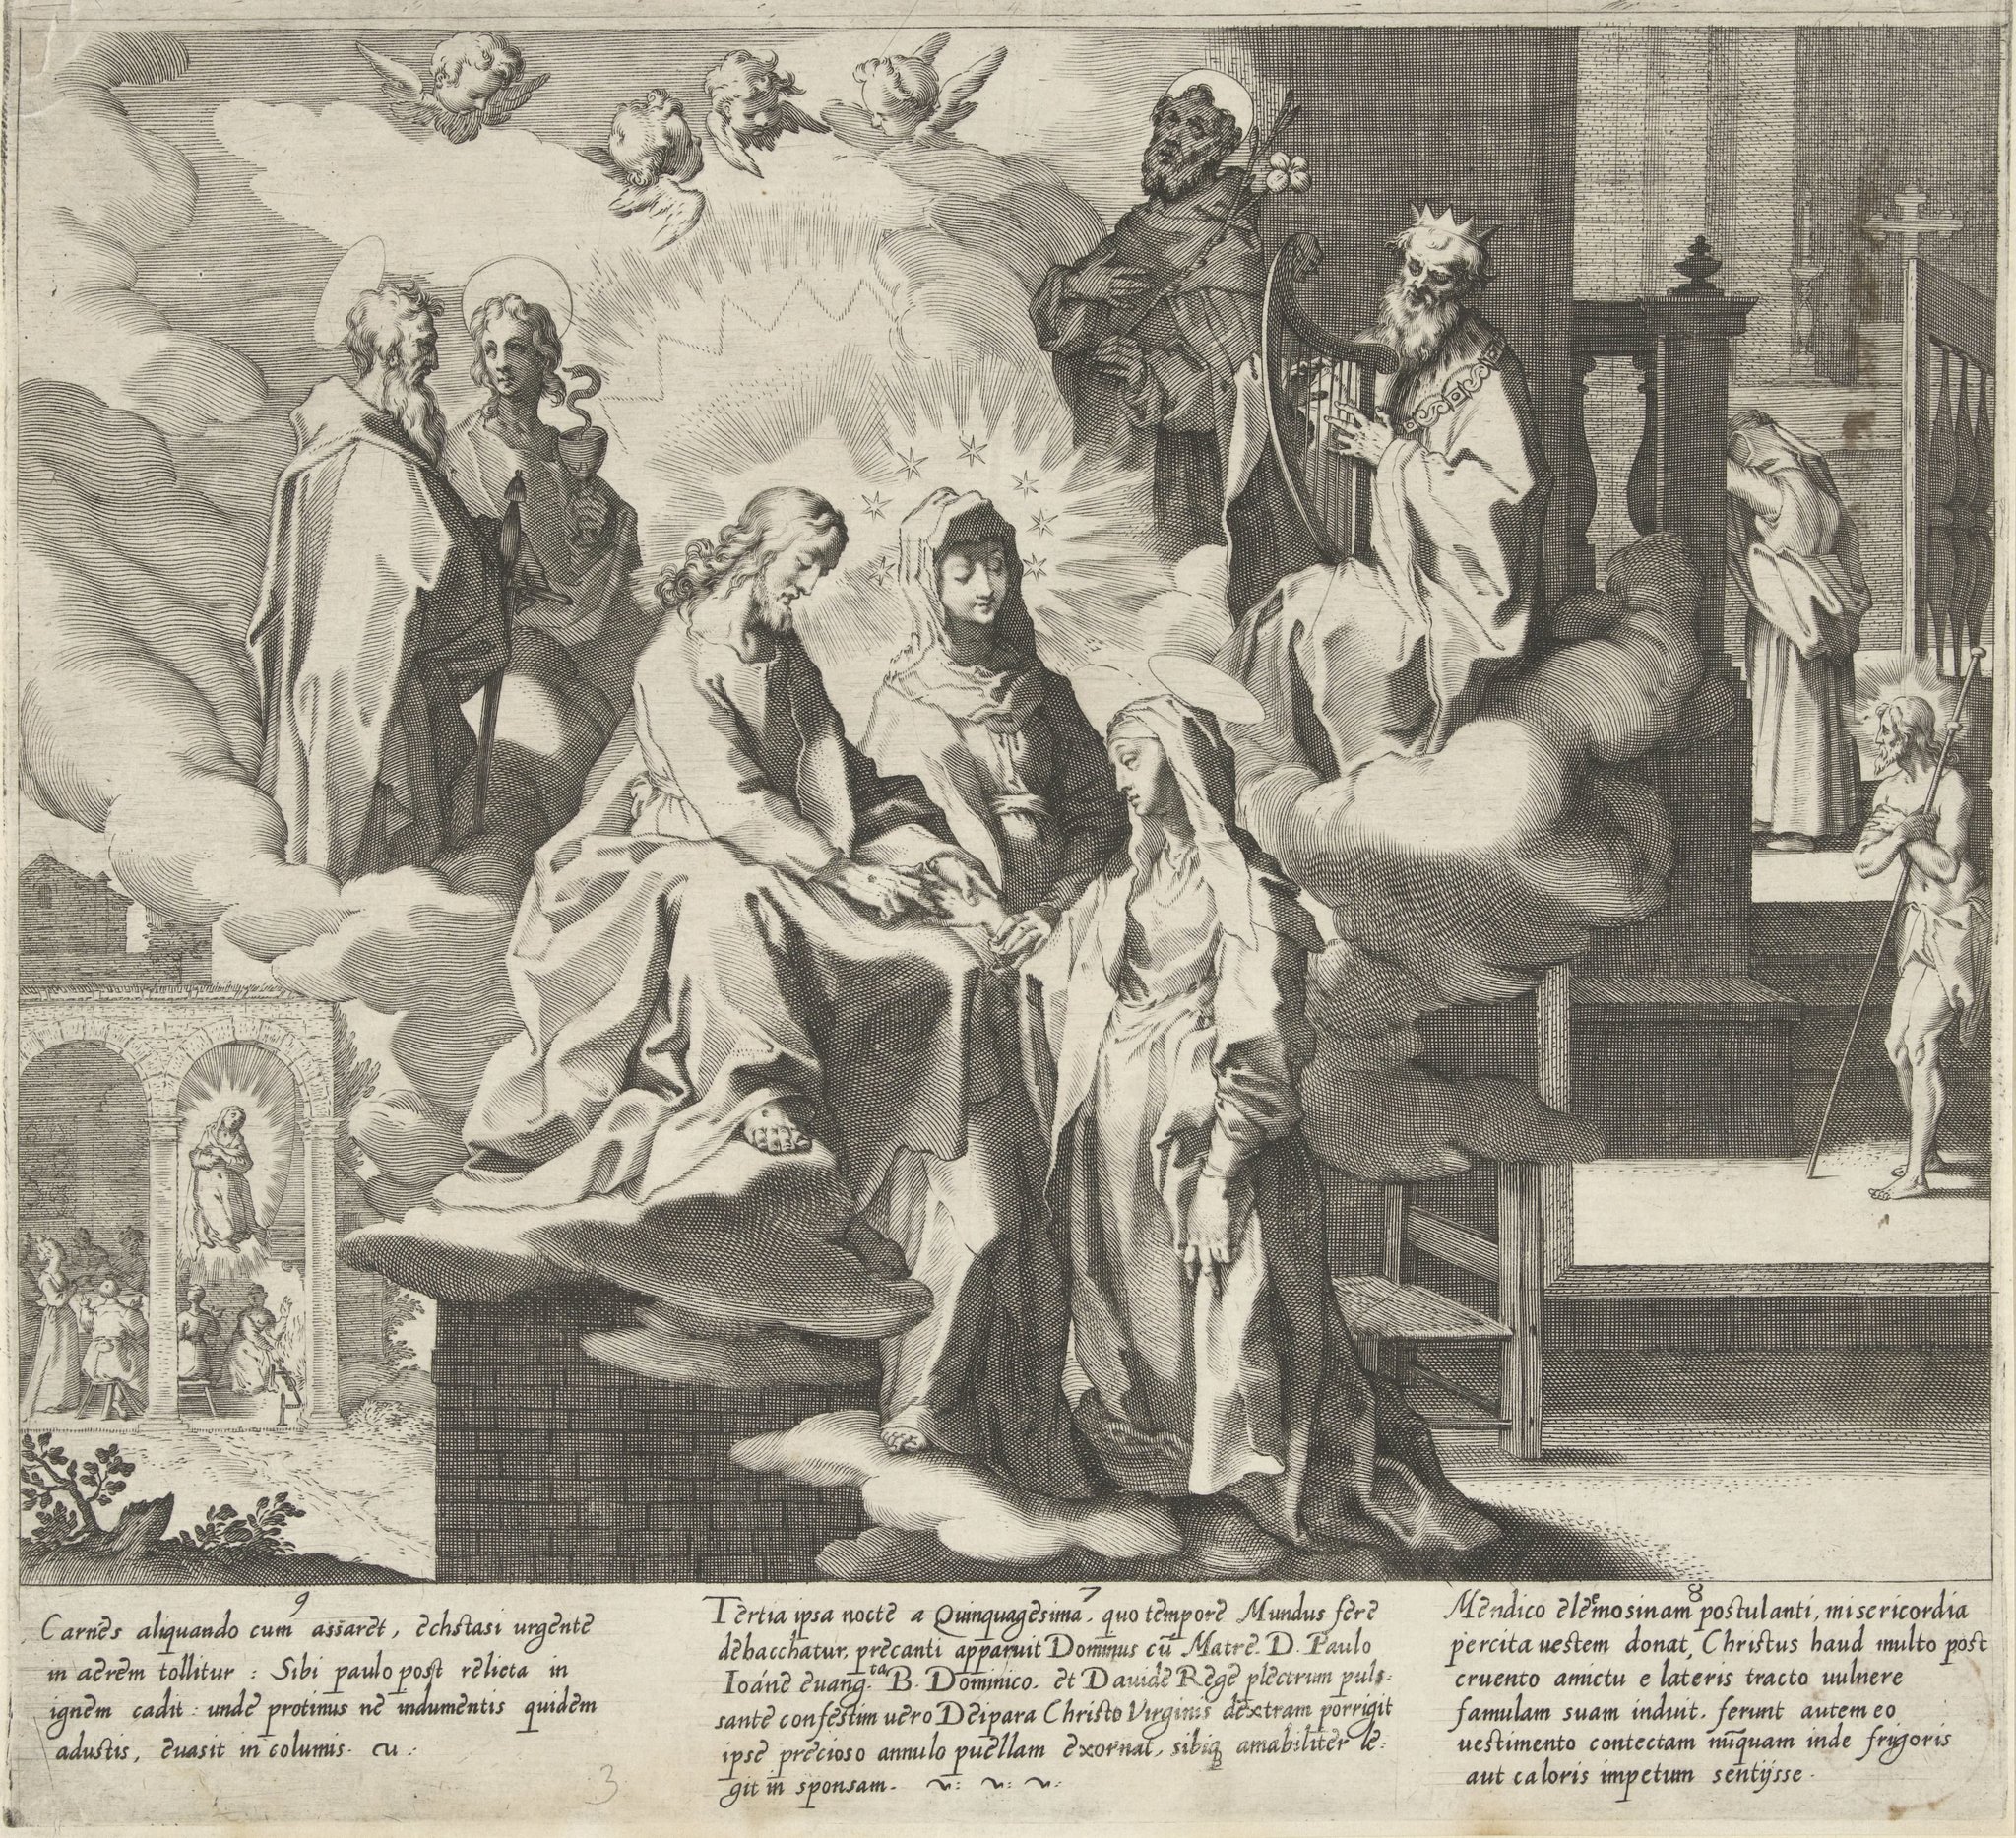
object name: print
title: Vita mors gesta, et miracula quaedam selecta B. CATHERINAE SENENSIS (...)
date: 1597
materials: paper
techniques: engraving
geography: italy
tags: the virgin and dominican tertiary, catherine of siena; possible attributes: book, cross, crown of thorns, crucifix, demon under foot, heart (with cross), lily, plague-stricken, ring, rosary, stigmata, the mystic marriage of st. catherine of siena: she kneels to receive a ring from the infant christ (in mary's lap), or from the adult christ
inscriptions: collector's mark: Lugt 240